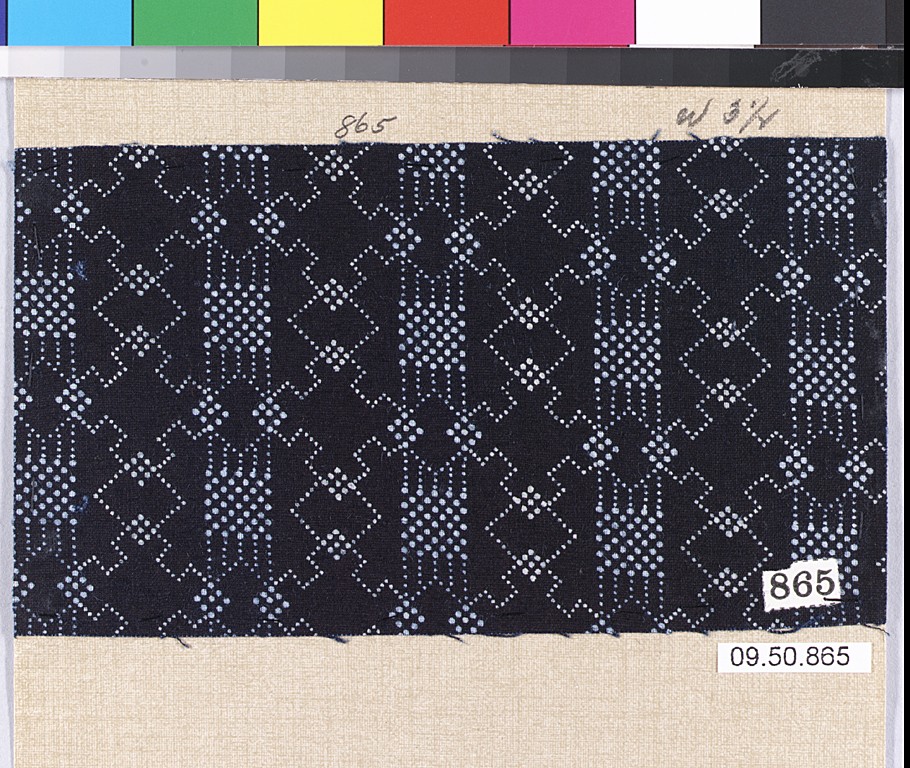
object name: piece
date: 1801-1900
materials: cotton